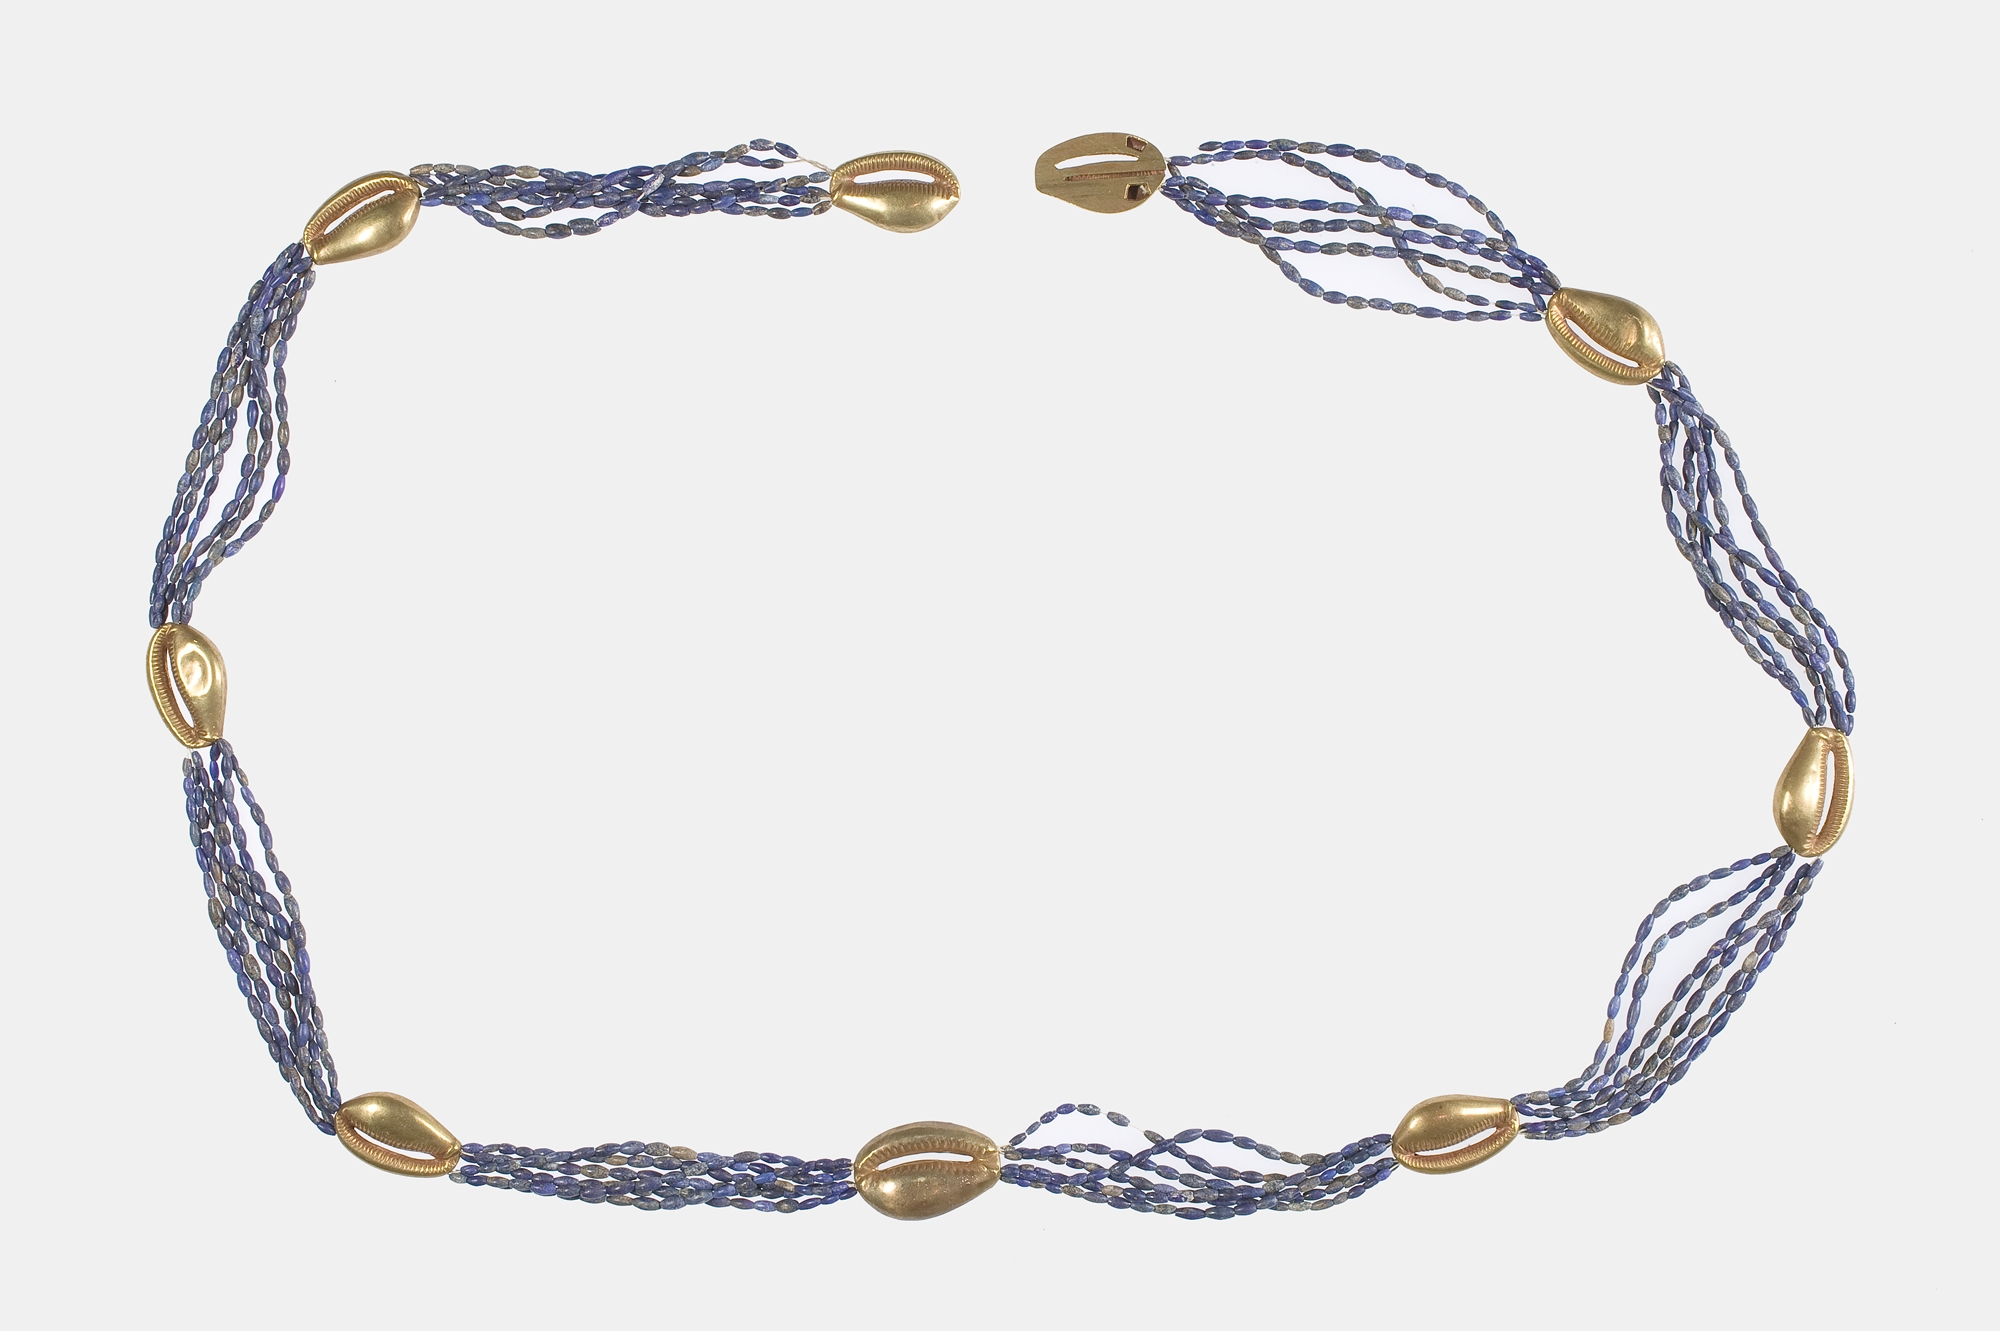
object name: girdle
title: Girdle of Hepy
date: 1950-1885 BCE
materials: gold, lapis lazuli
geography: egypt